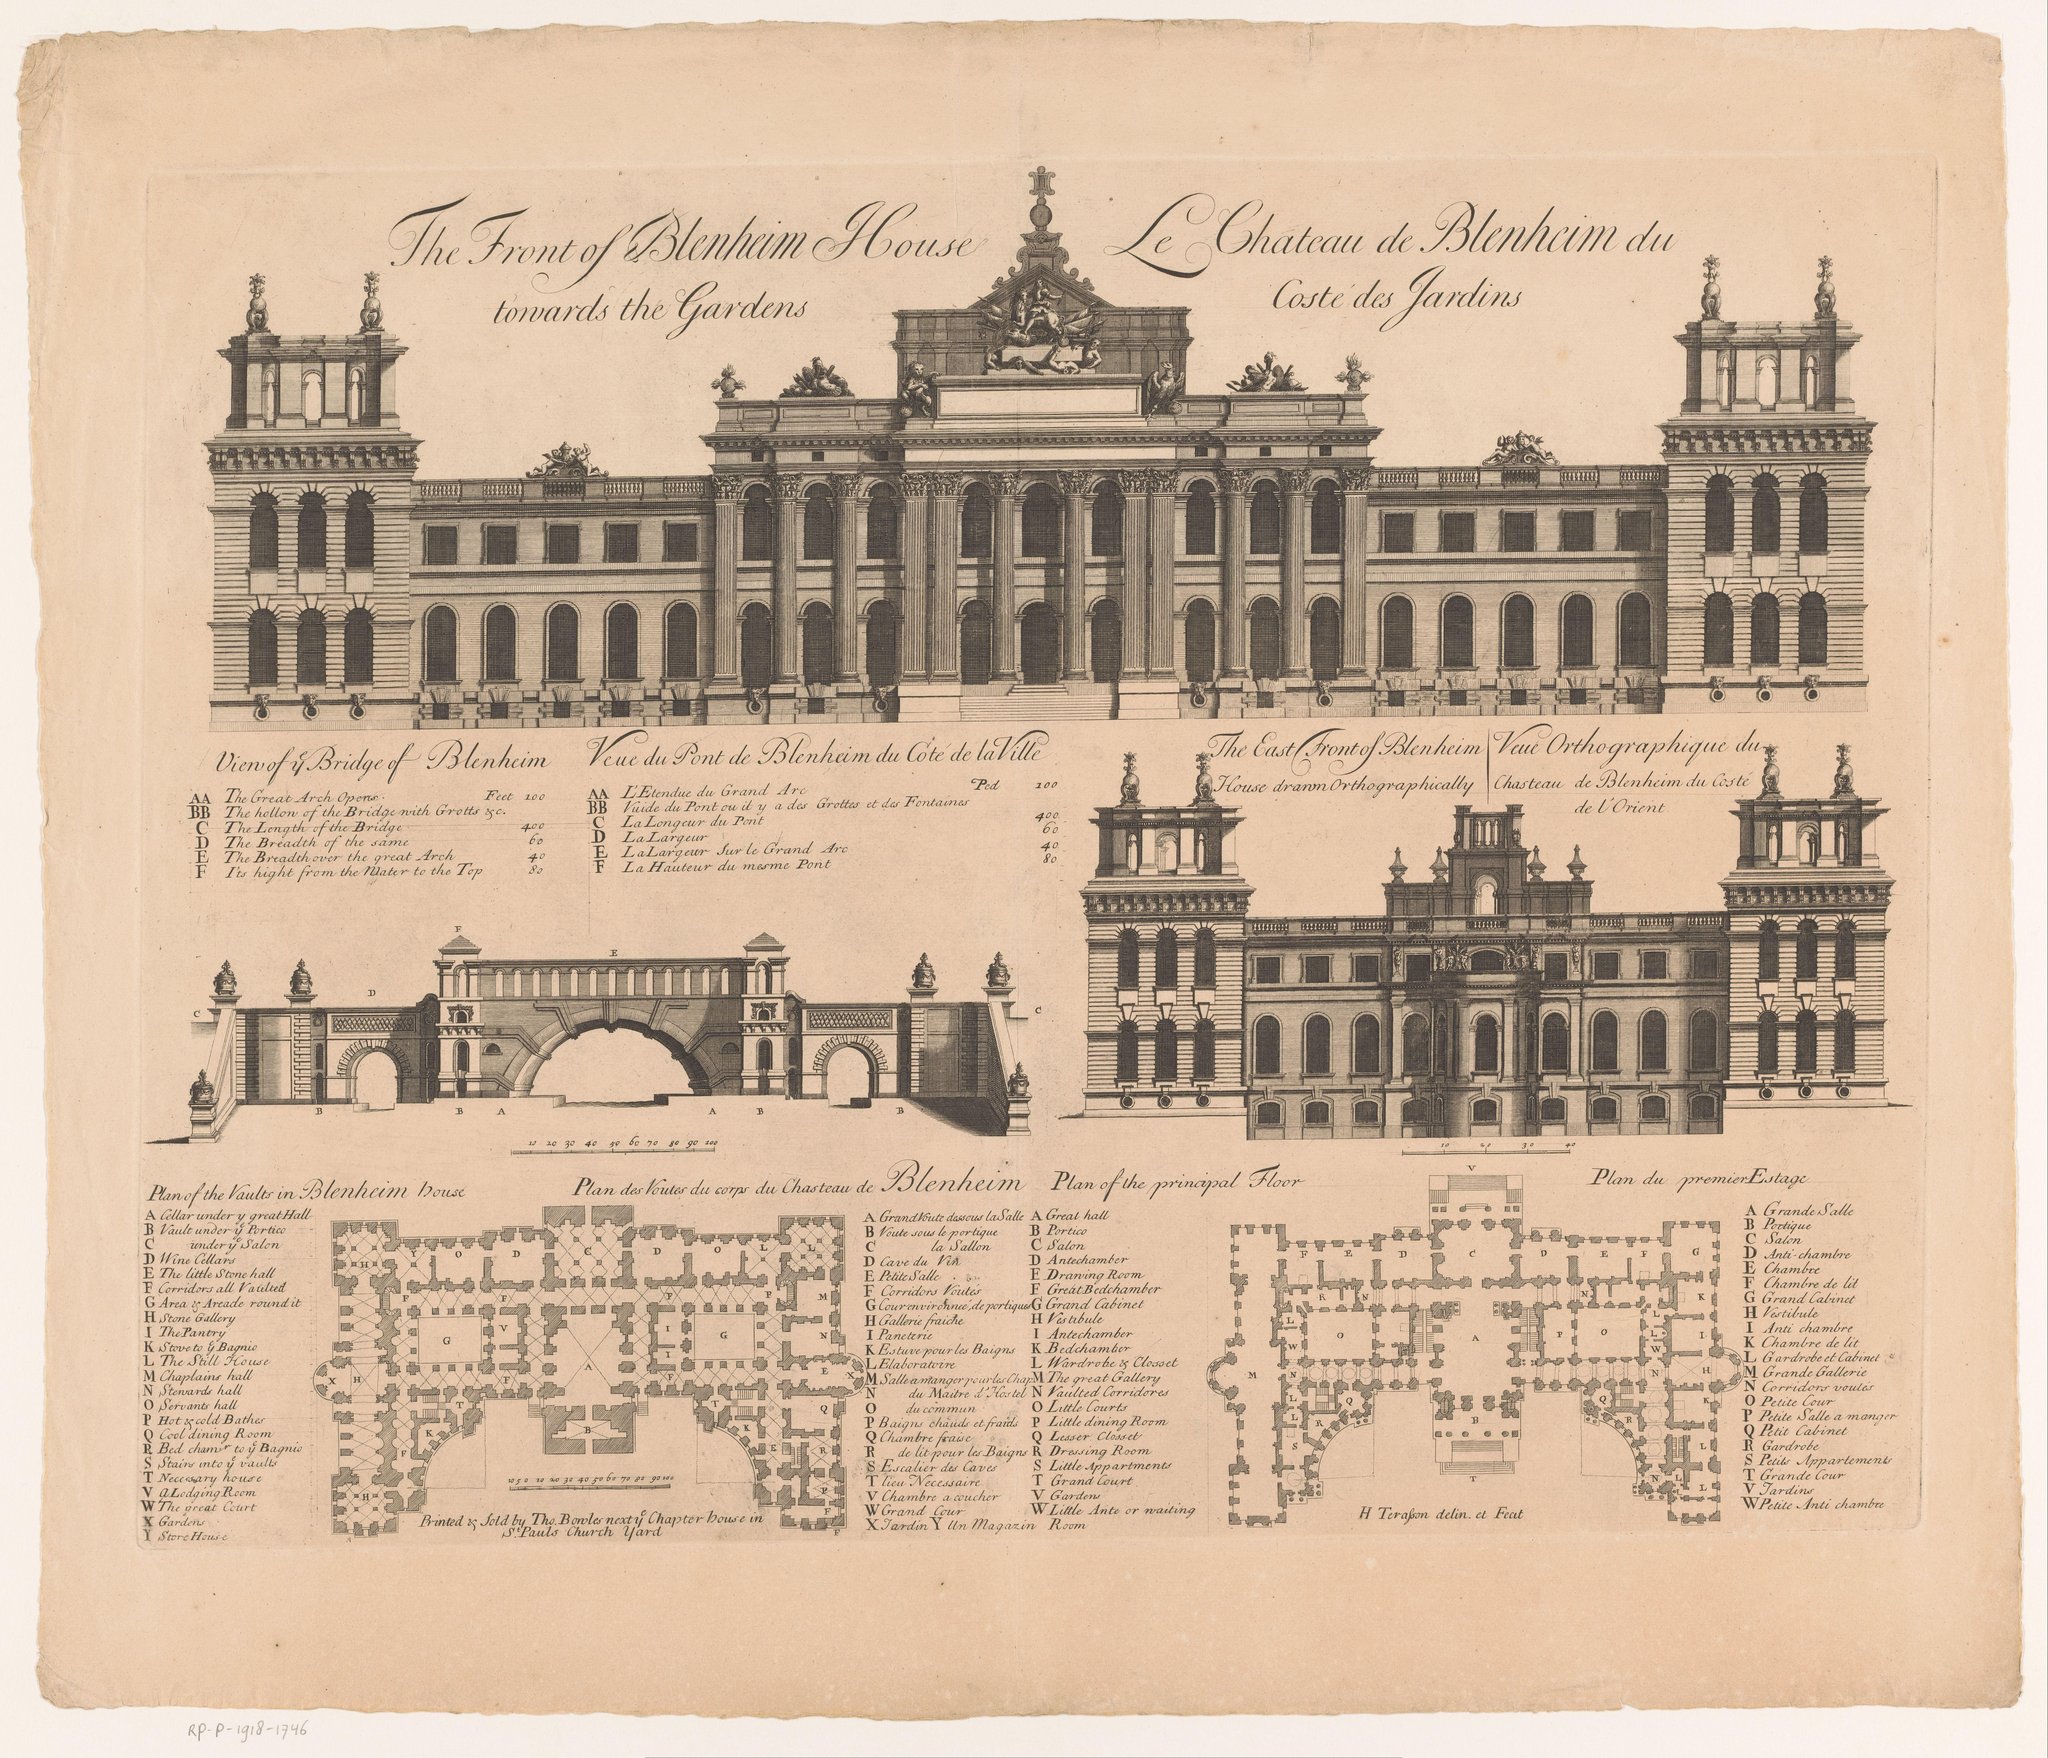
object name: print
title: The Frond of Blenheim House towards the Gardens / Le Chateau de Blenheim du Costé des Jardins (...)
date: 1724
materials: paper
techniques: etching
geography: london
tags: palace, architectural design or model, bridge, plan ~ architecture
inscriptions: collector's mark: Lugt 2233